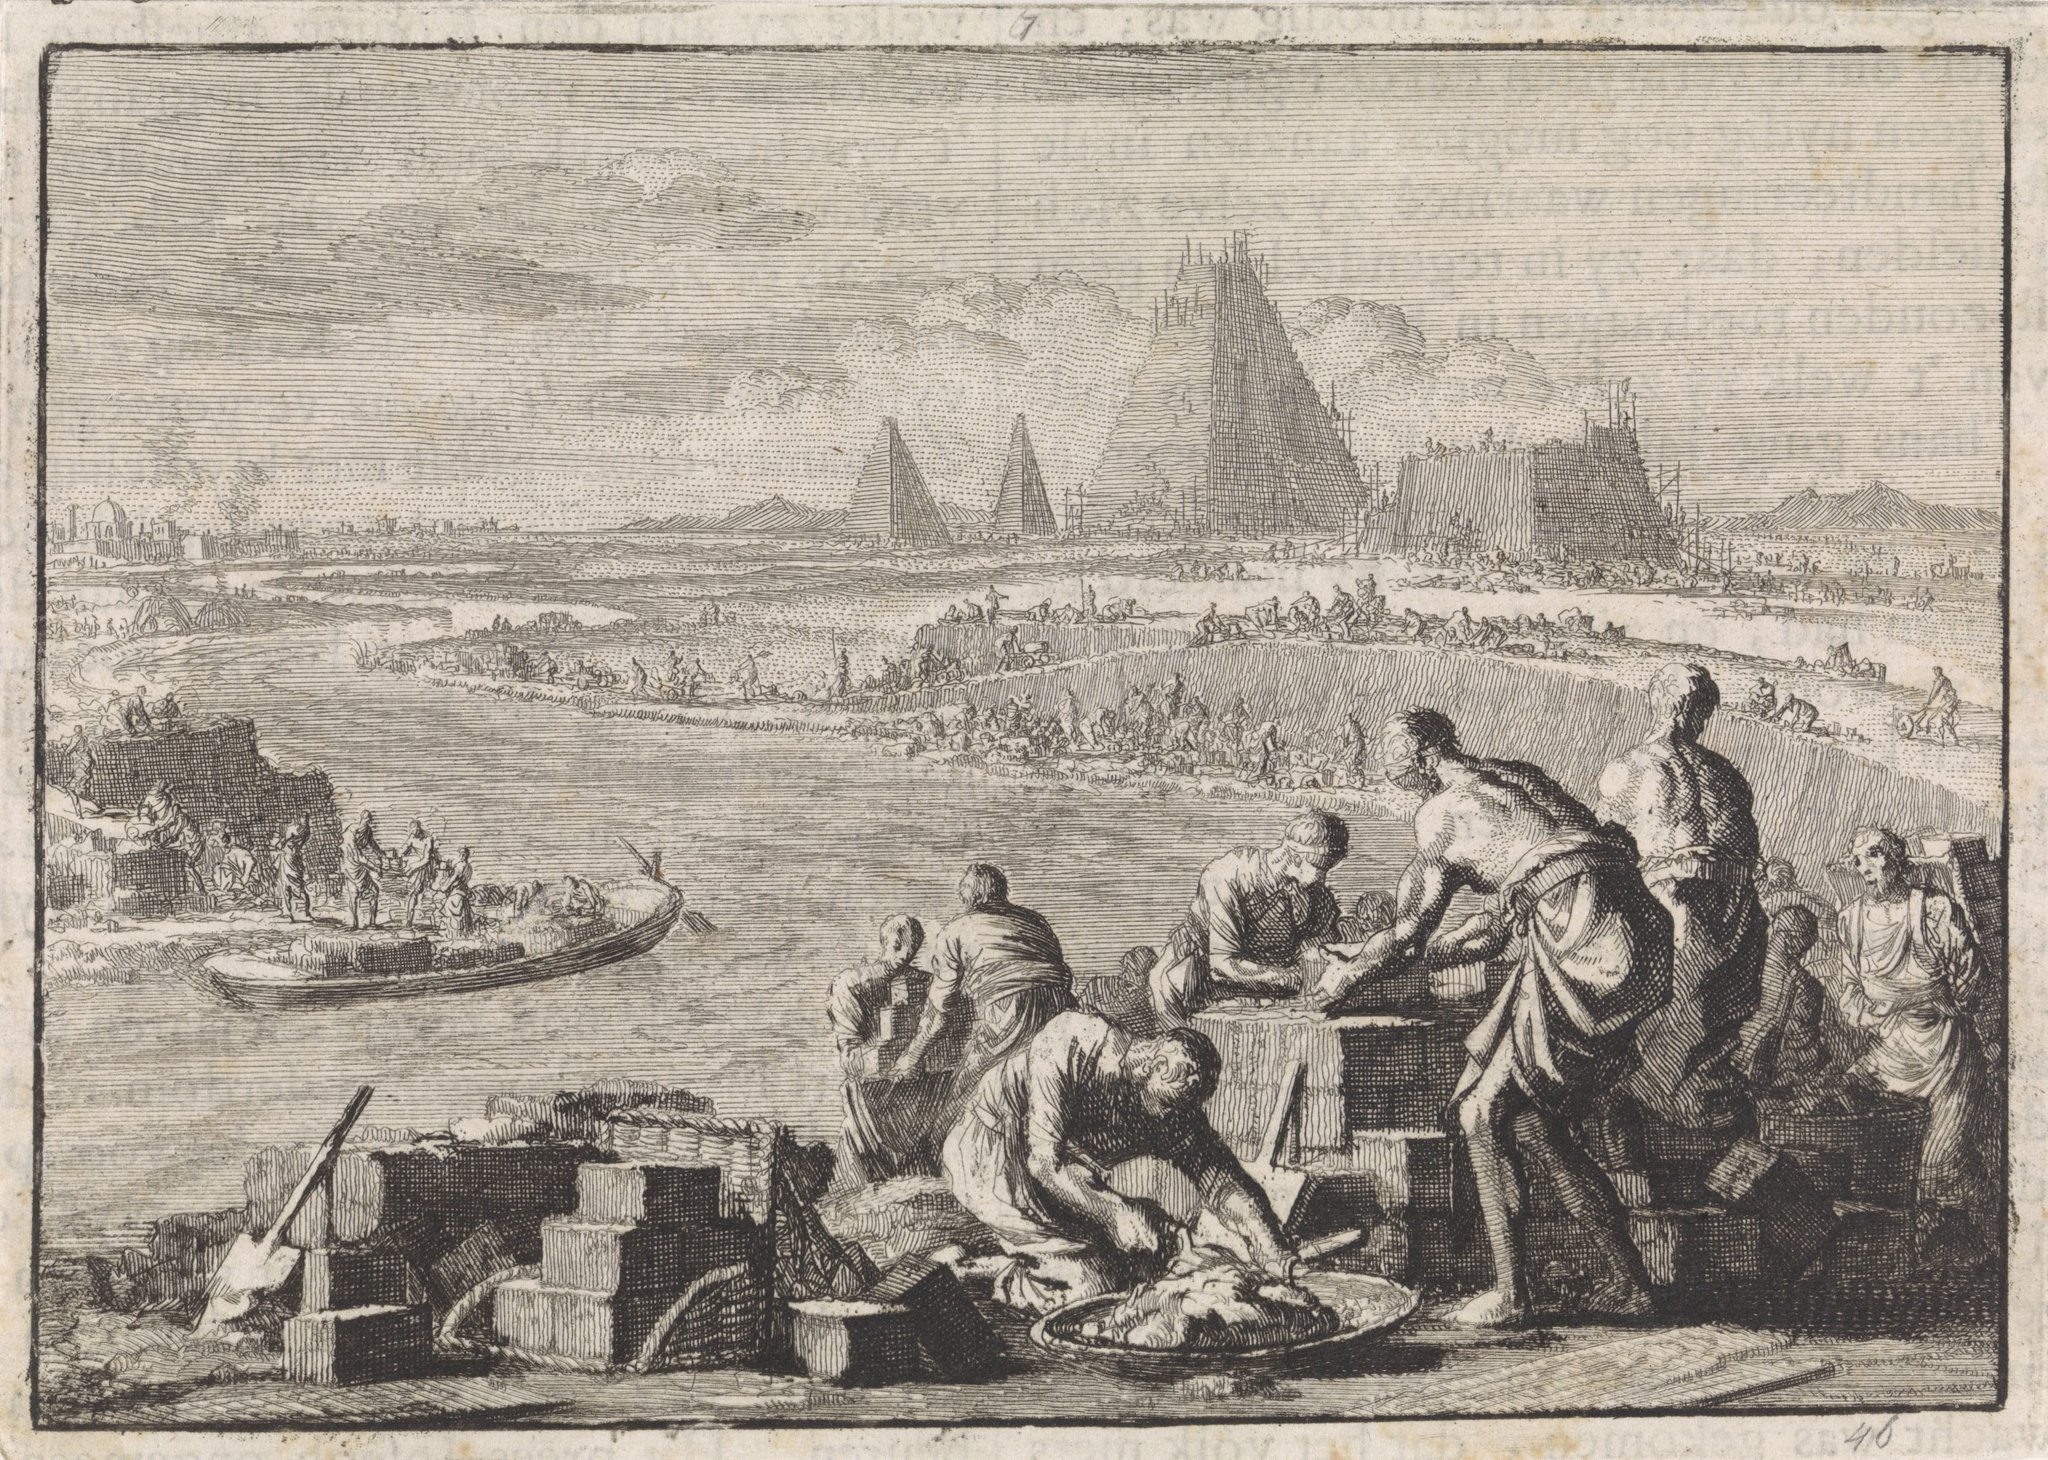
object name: print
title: Onderdrukking van de Israëlieten in Egypte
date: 1704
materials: paper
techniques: etching, letterpress printing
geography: amsterdam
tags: oppression of the israelites in egypt (exodus 1)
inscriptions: collector's mark: Lugt 2228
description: Prent opgenomen in: Josephus, Flavius. Alle de Werken, 2 delen. Amsterdam: Pieter Mortier, 1704, dl. 1, p. 46.